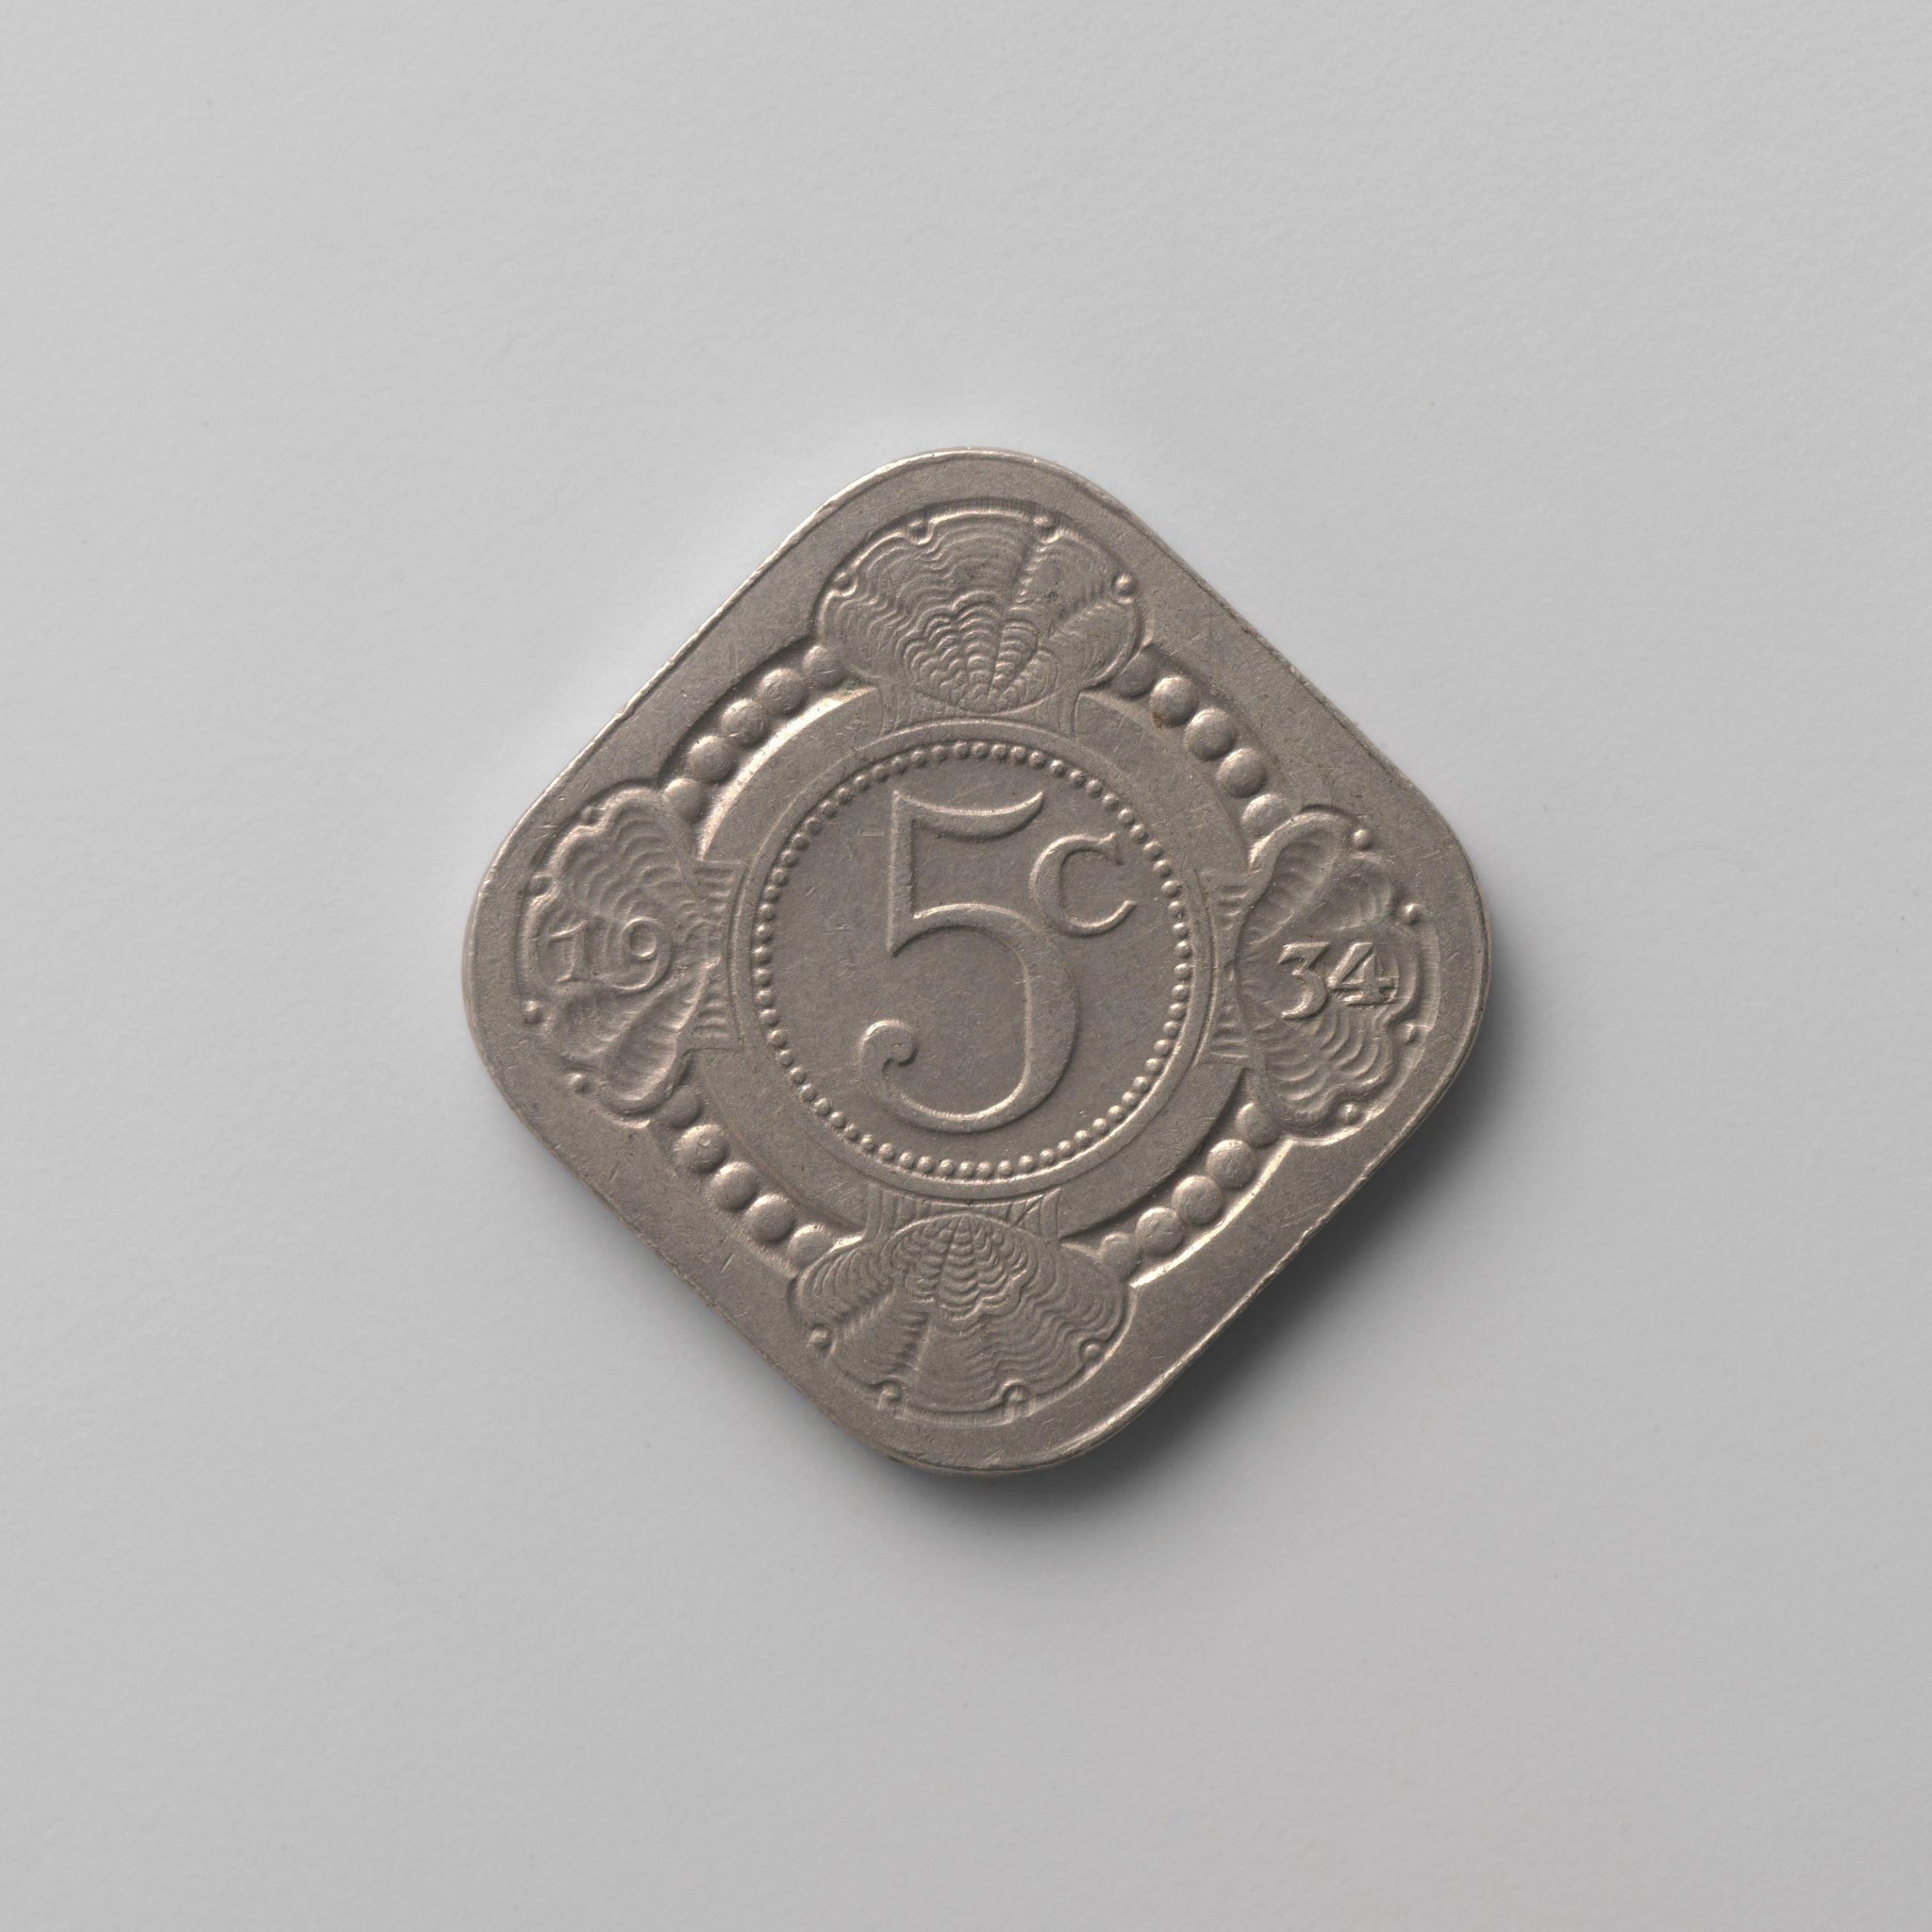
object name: coin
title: Nederland, 5 cent,1934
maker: wilhelmina of the netherlands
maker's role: print maker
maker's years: 1880-1962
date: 1934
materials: nickel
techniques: striking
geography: utrecht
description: Vierkante nikkelen munt. Voorzijde: in hoeken versiering, daarbinnen twee cirkels, waarin landsaanduiding. Daarbinnen vruchtdragende tak van een oranje-appel. Keerzijde: in de vier hoeken schelpen-versiering, verbonden door parels. Daarbinnen waarde-aanduiding 5 C in parelrand. Jaartal in de twee schelpen links en rechts. Gladde rand.